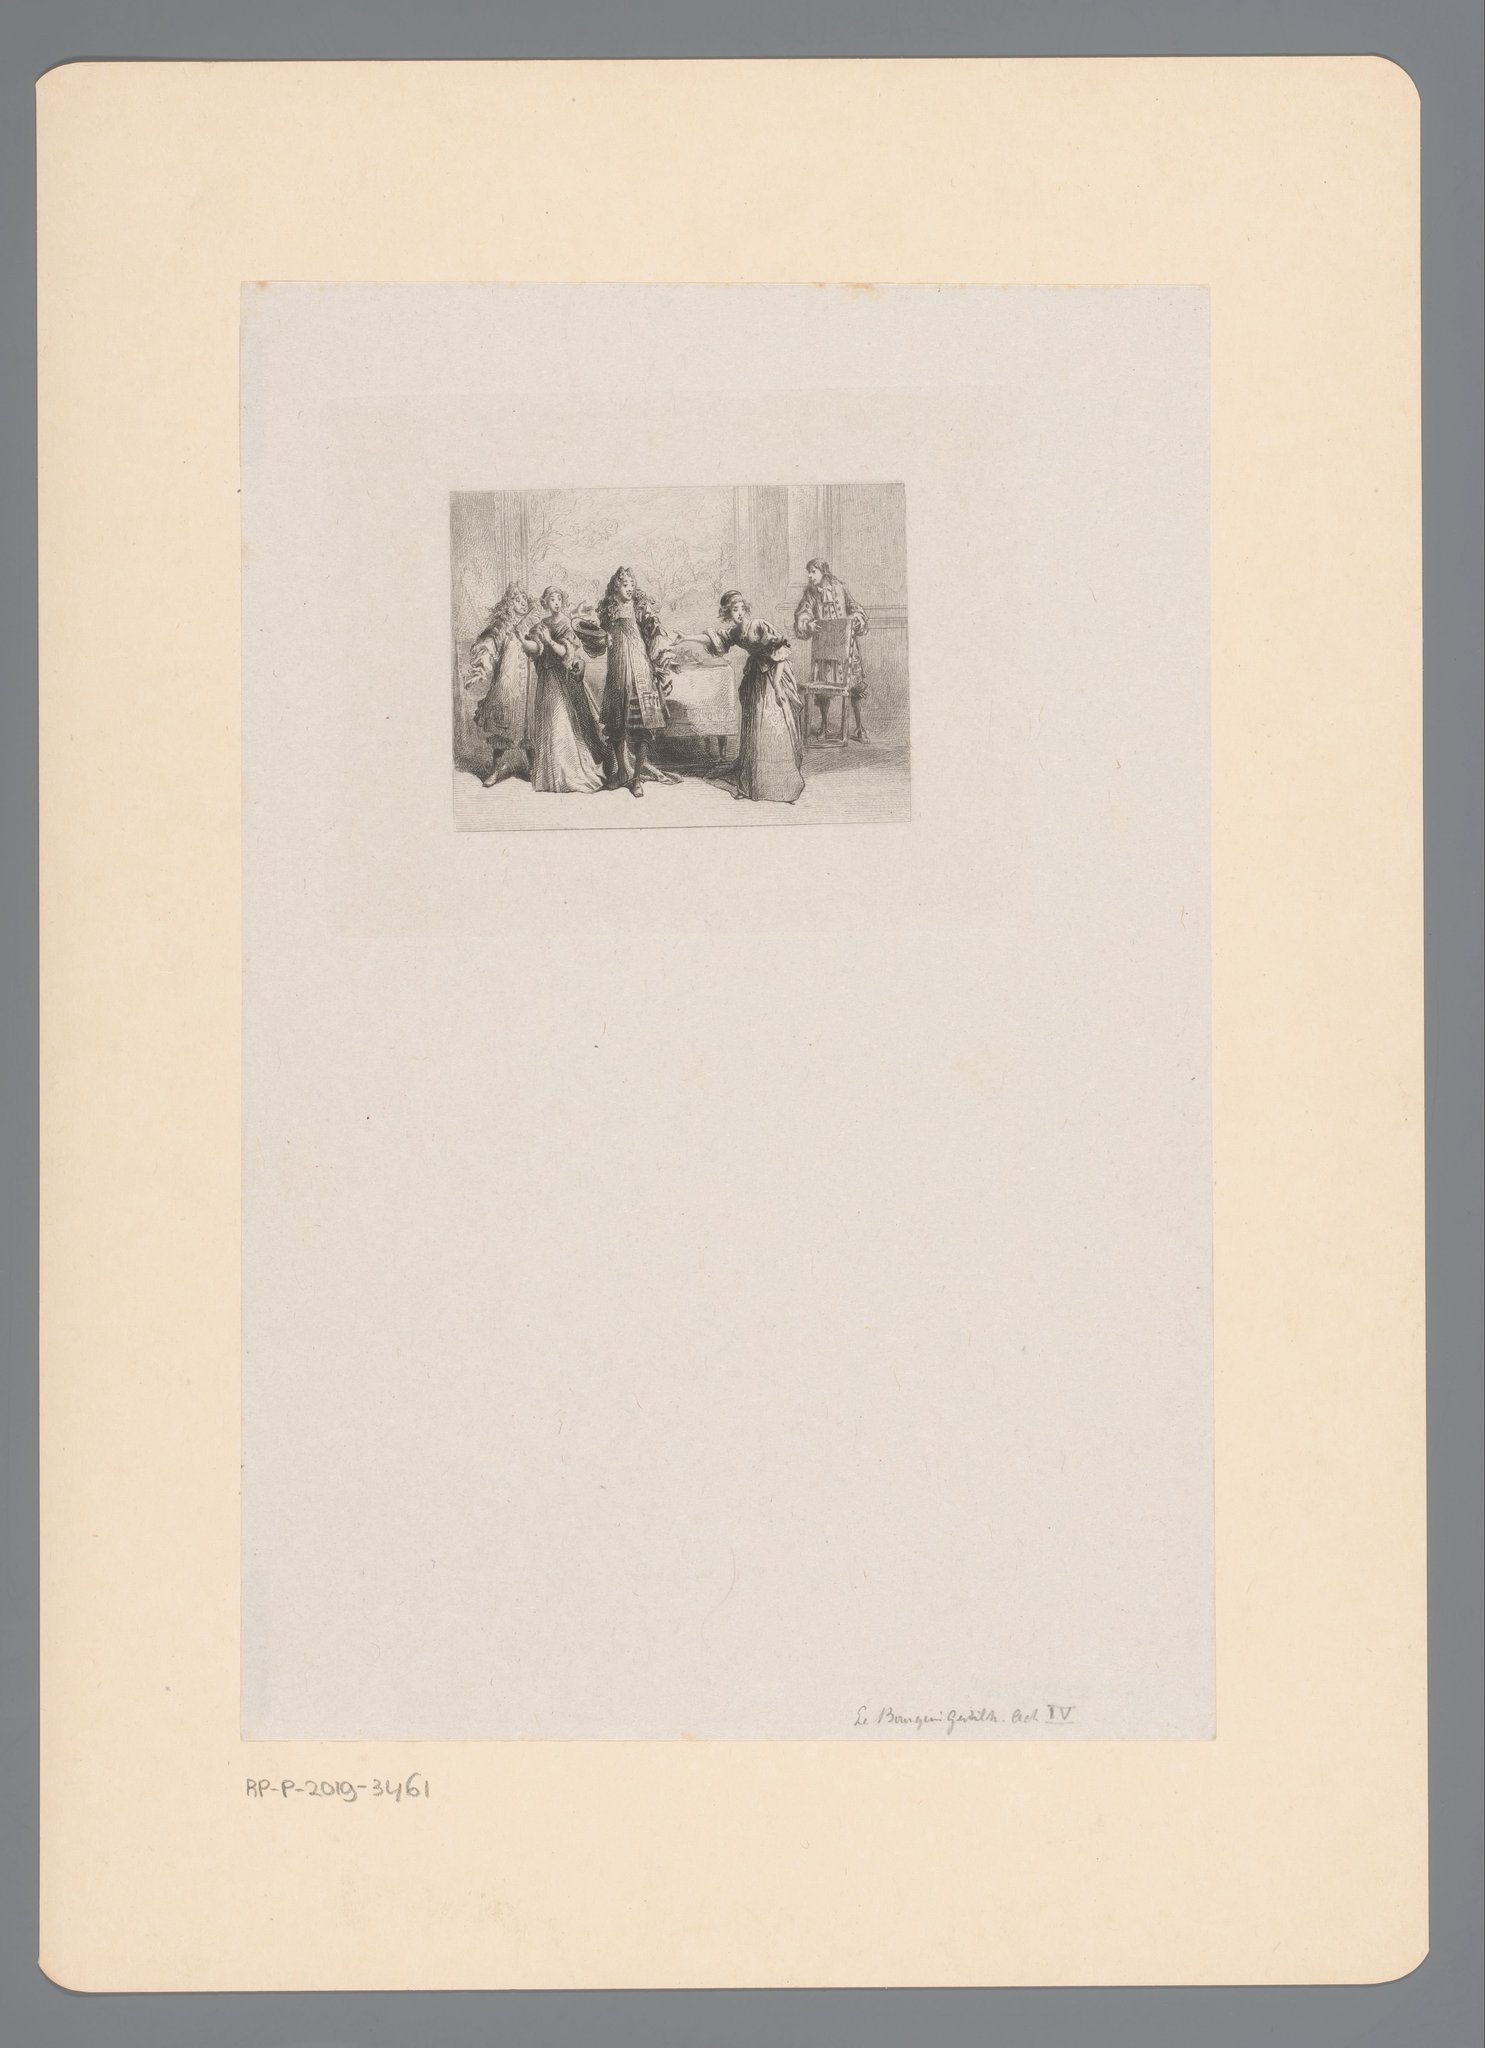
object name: print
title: Interieur met elegant gezelschap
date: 1878-1879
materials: paper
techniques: drypoint, etching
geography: tours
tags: theatre, theatrical performance, visiting; receiving guests; elegant company, interior of the house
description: Scène uit akte IV uit "Le Bourgeois Gentilhomme" van Molière. Monsieur Jourdain en zijn gezelschap staand bij een tafel.